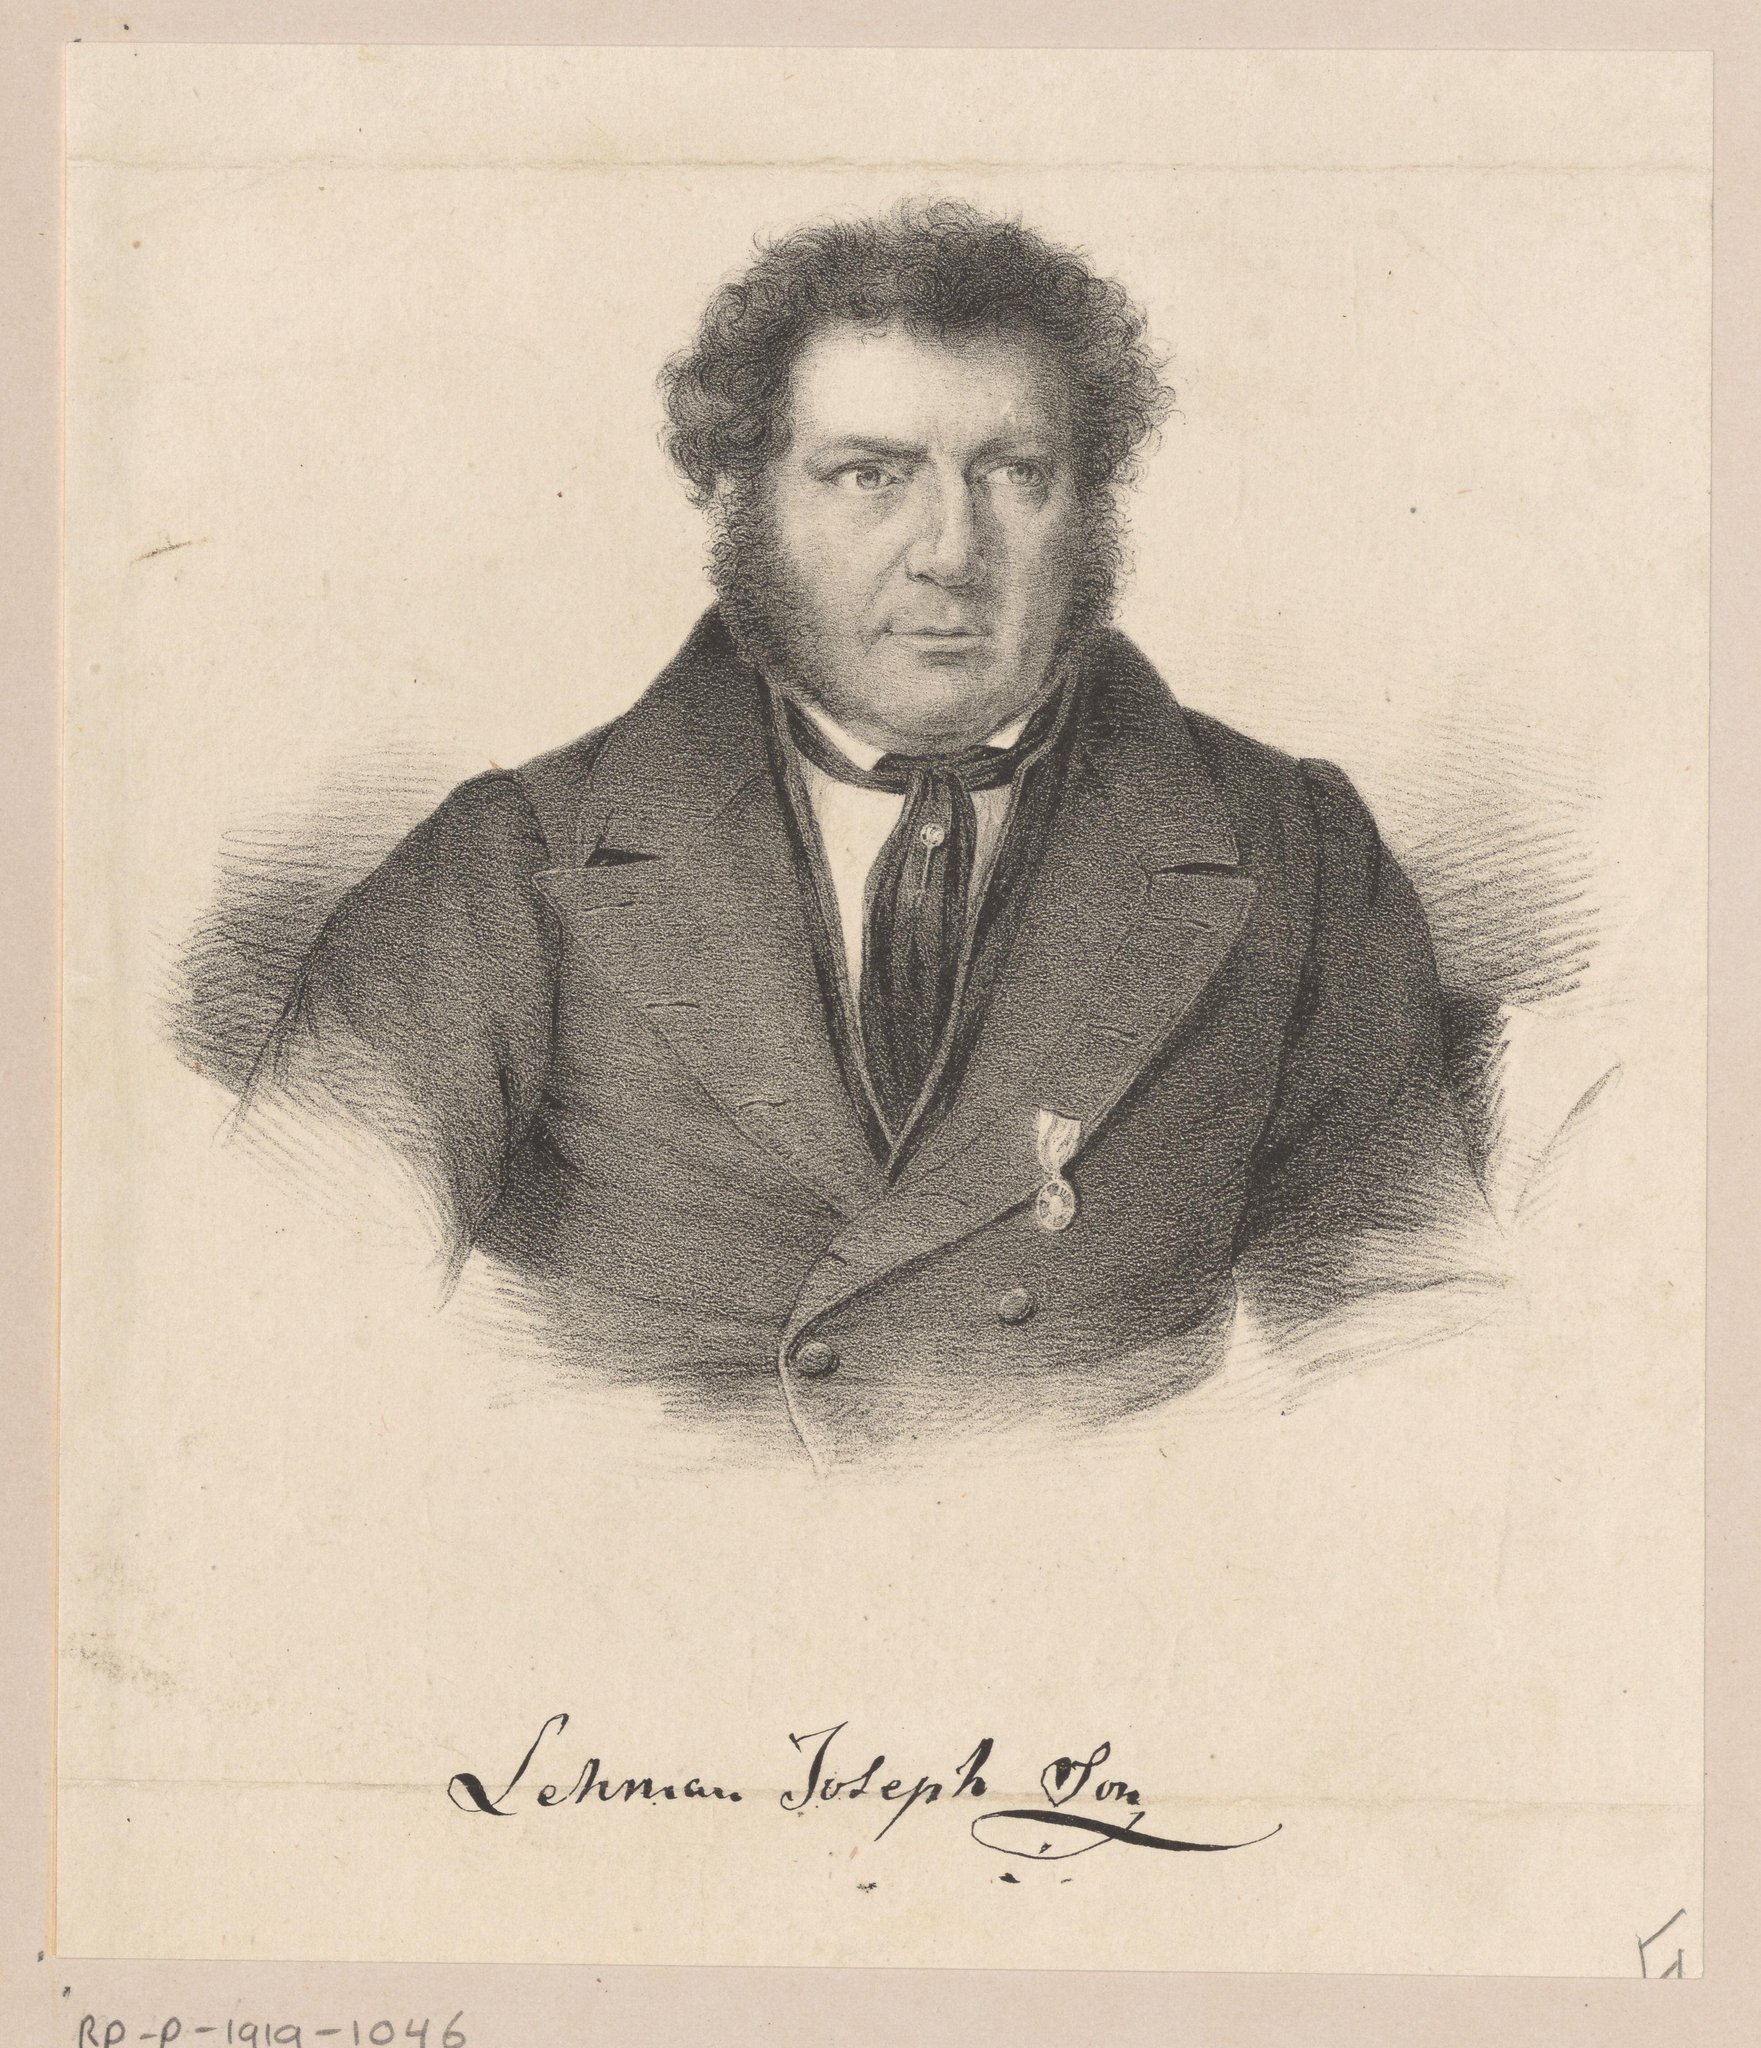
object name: print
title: Portret van Joseph Lehmann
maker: Anonymous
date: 1835-1899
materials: paper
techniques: lithograph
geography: germany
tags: journalist, reporter, historical persons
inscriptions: collector's mark: Lugt 2228